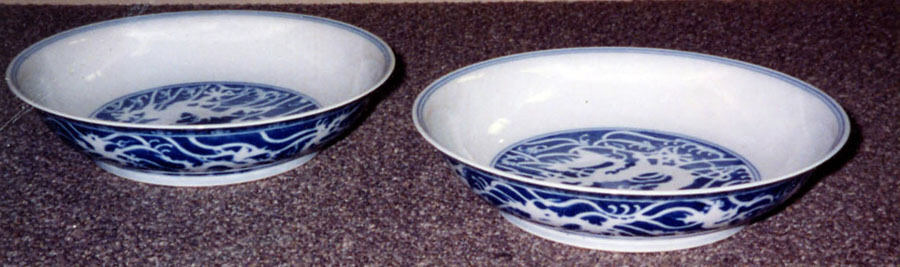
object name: dish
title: Dish (one of a pair)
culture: chinese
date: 1736-1795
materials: porcelain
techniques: painting, underglaze